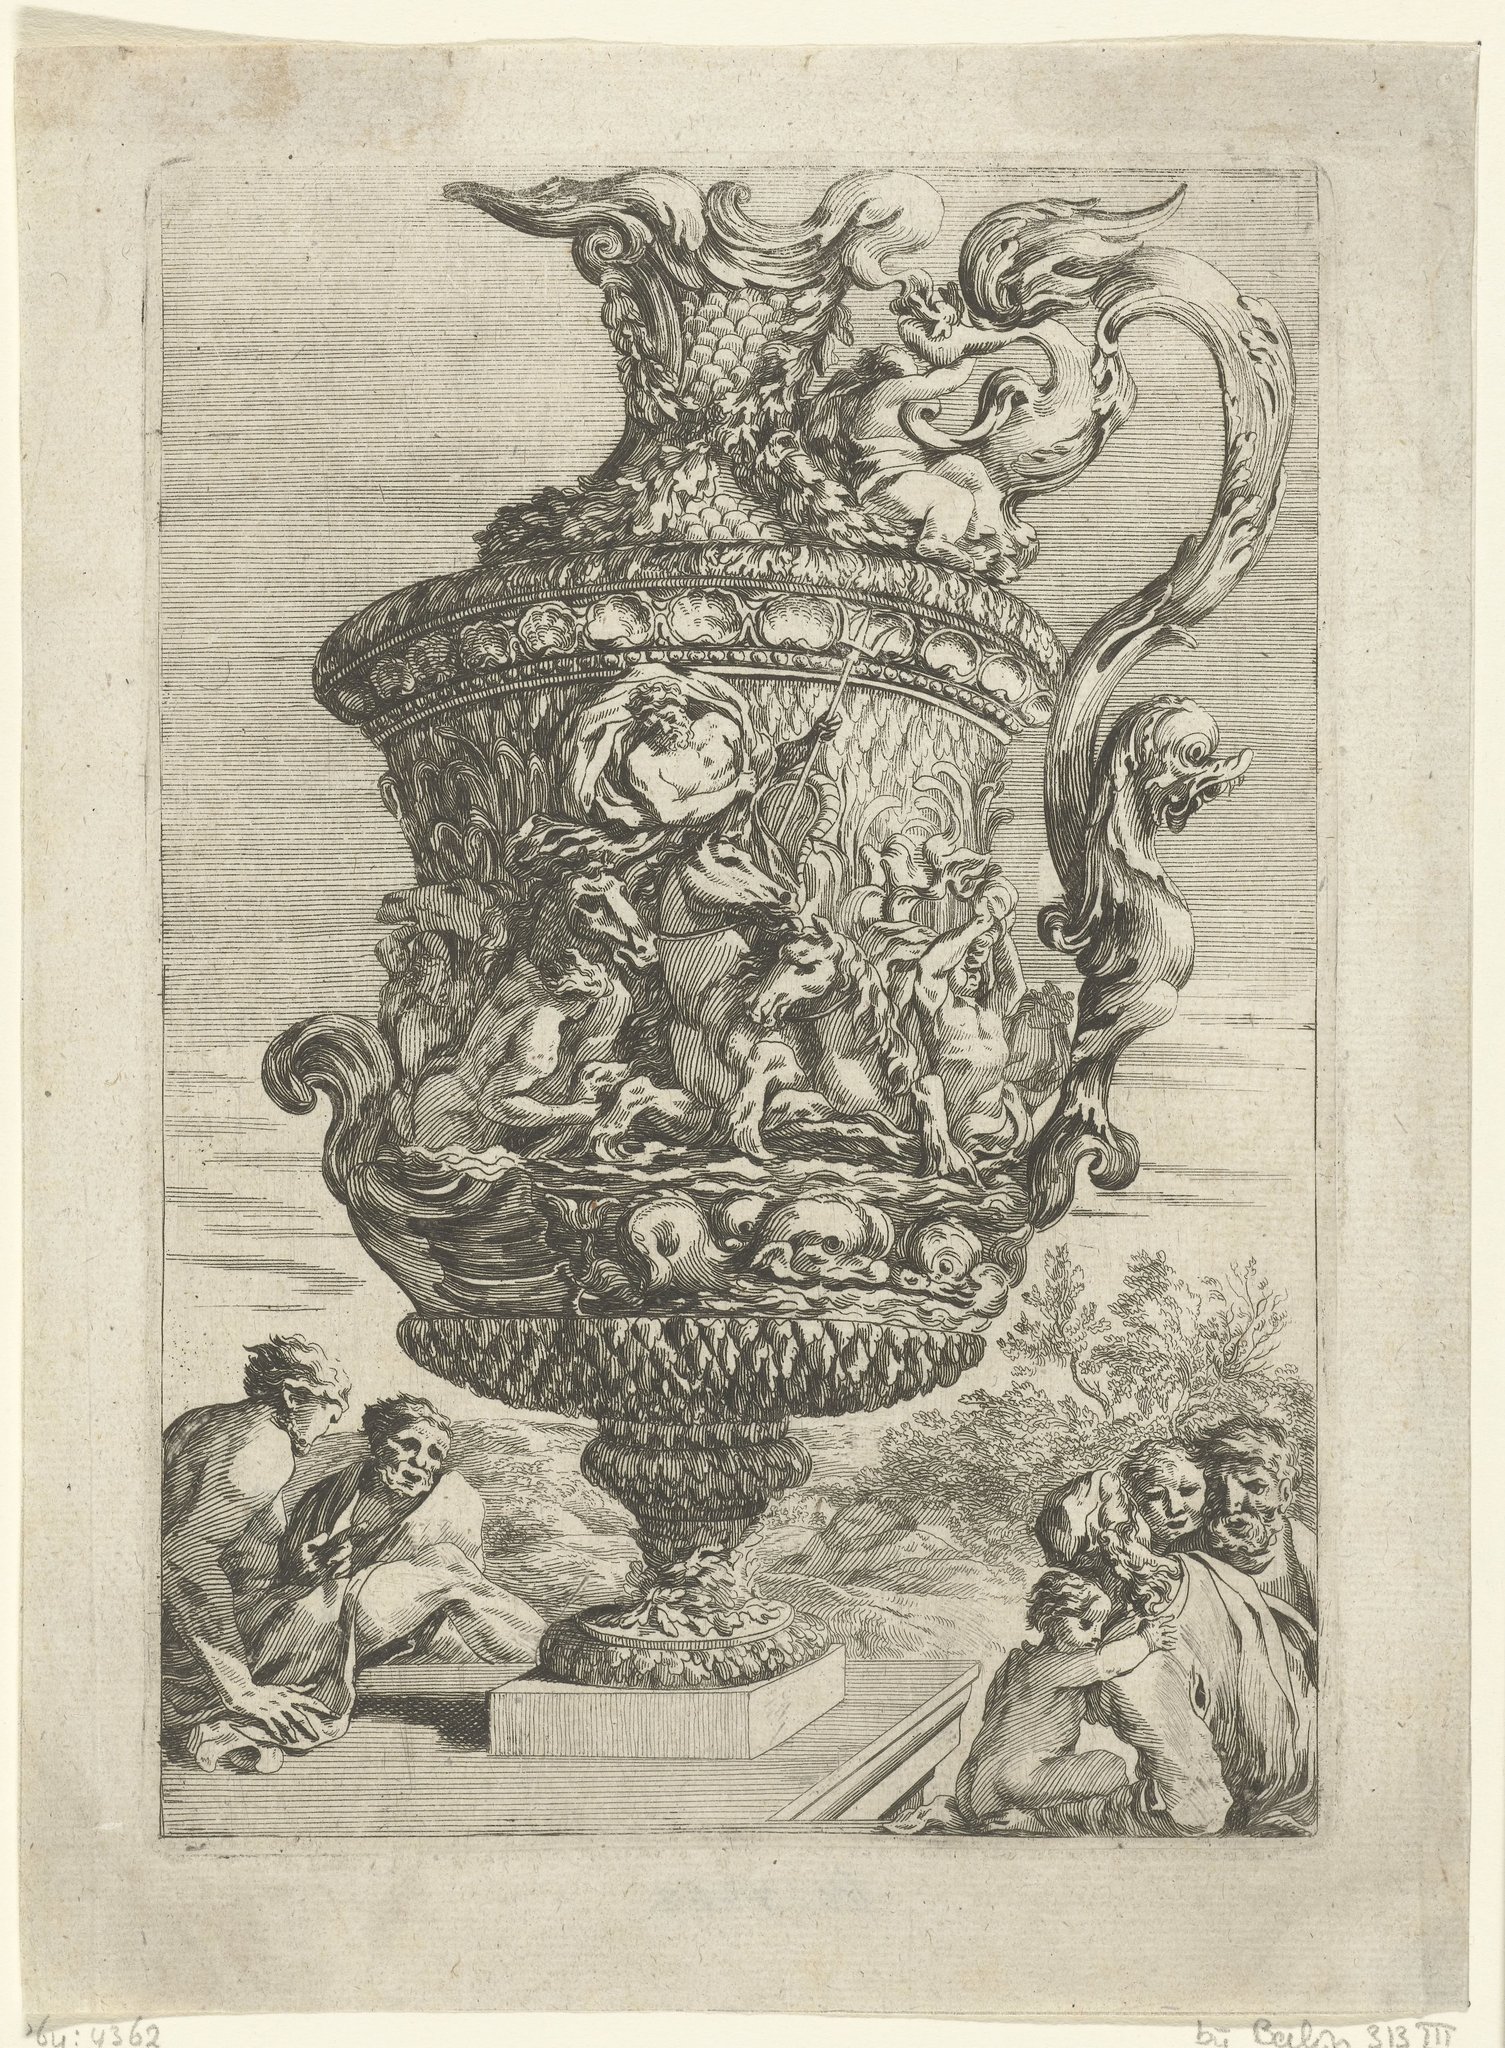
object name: ornament print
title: Schenkkan met Neptunus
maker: Anonymous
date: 1628-1732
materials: paper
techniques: etching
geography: netherlands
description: Het handvat van de kan wijst naar rechts. Uit serie van 6 bladen.